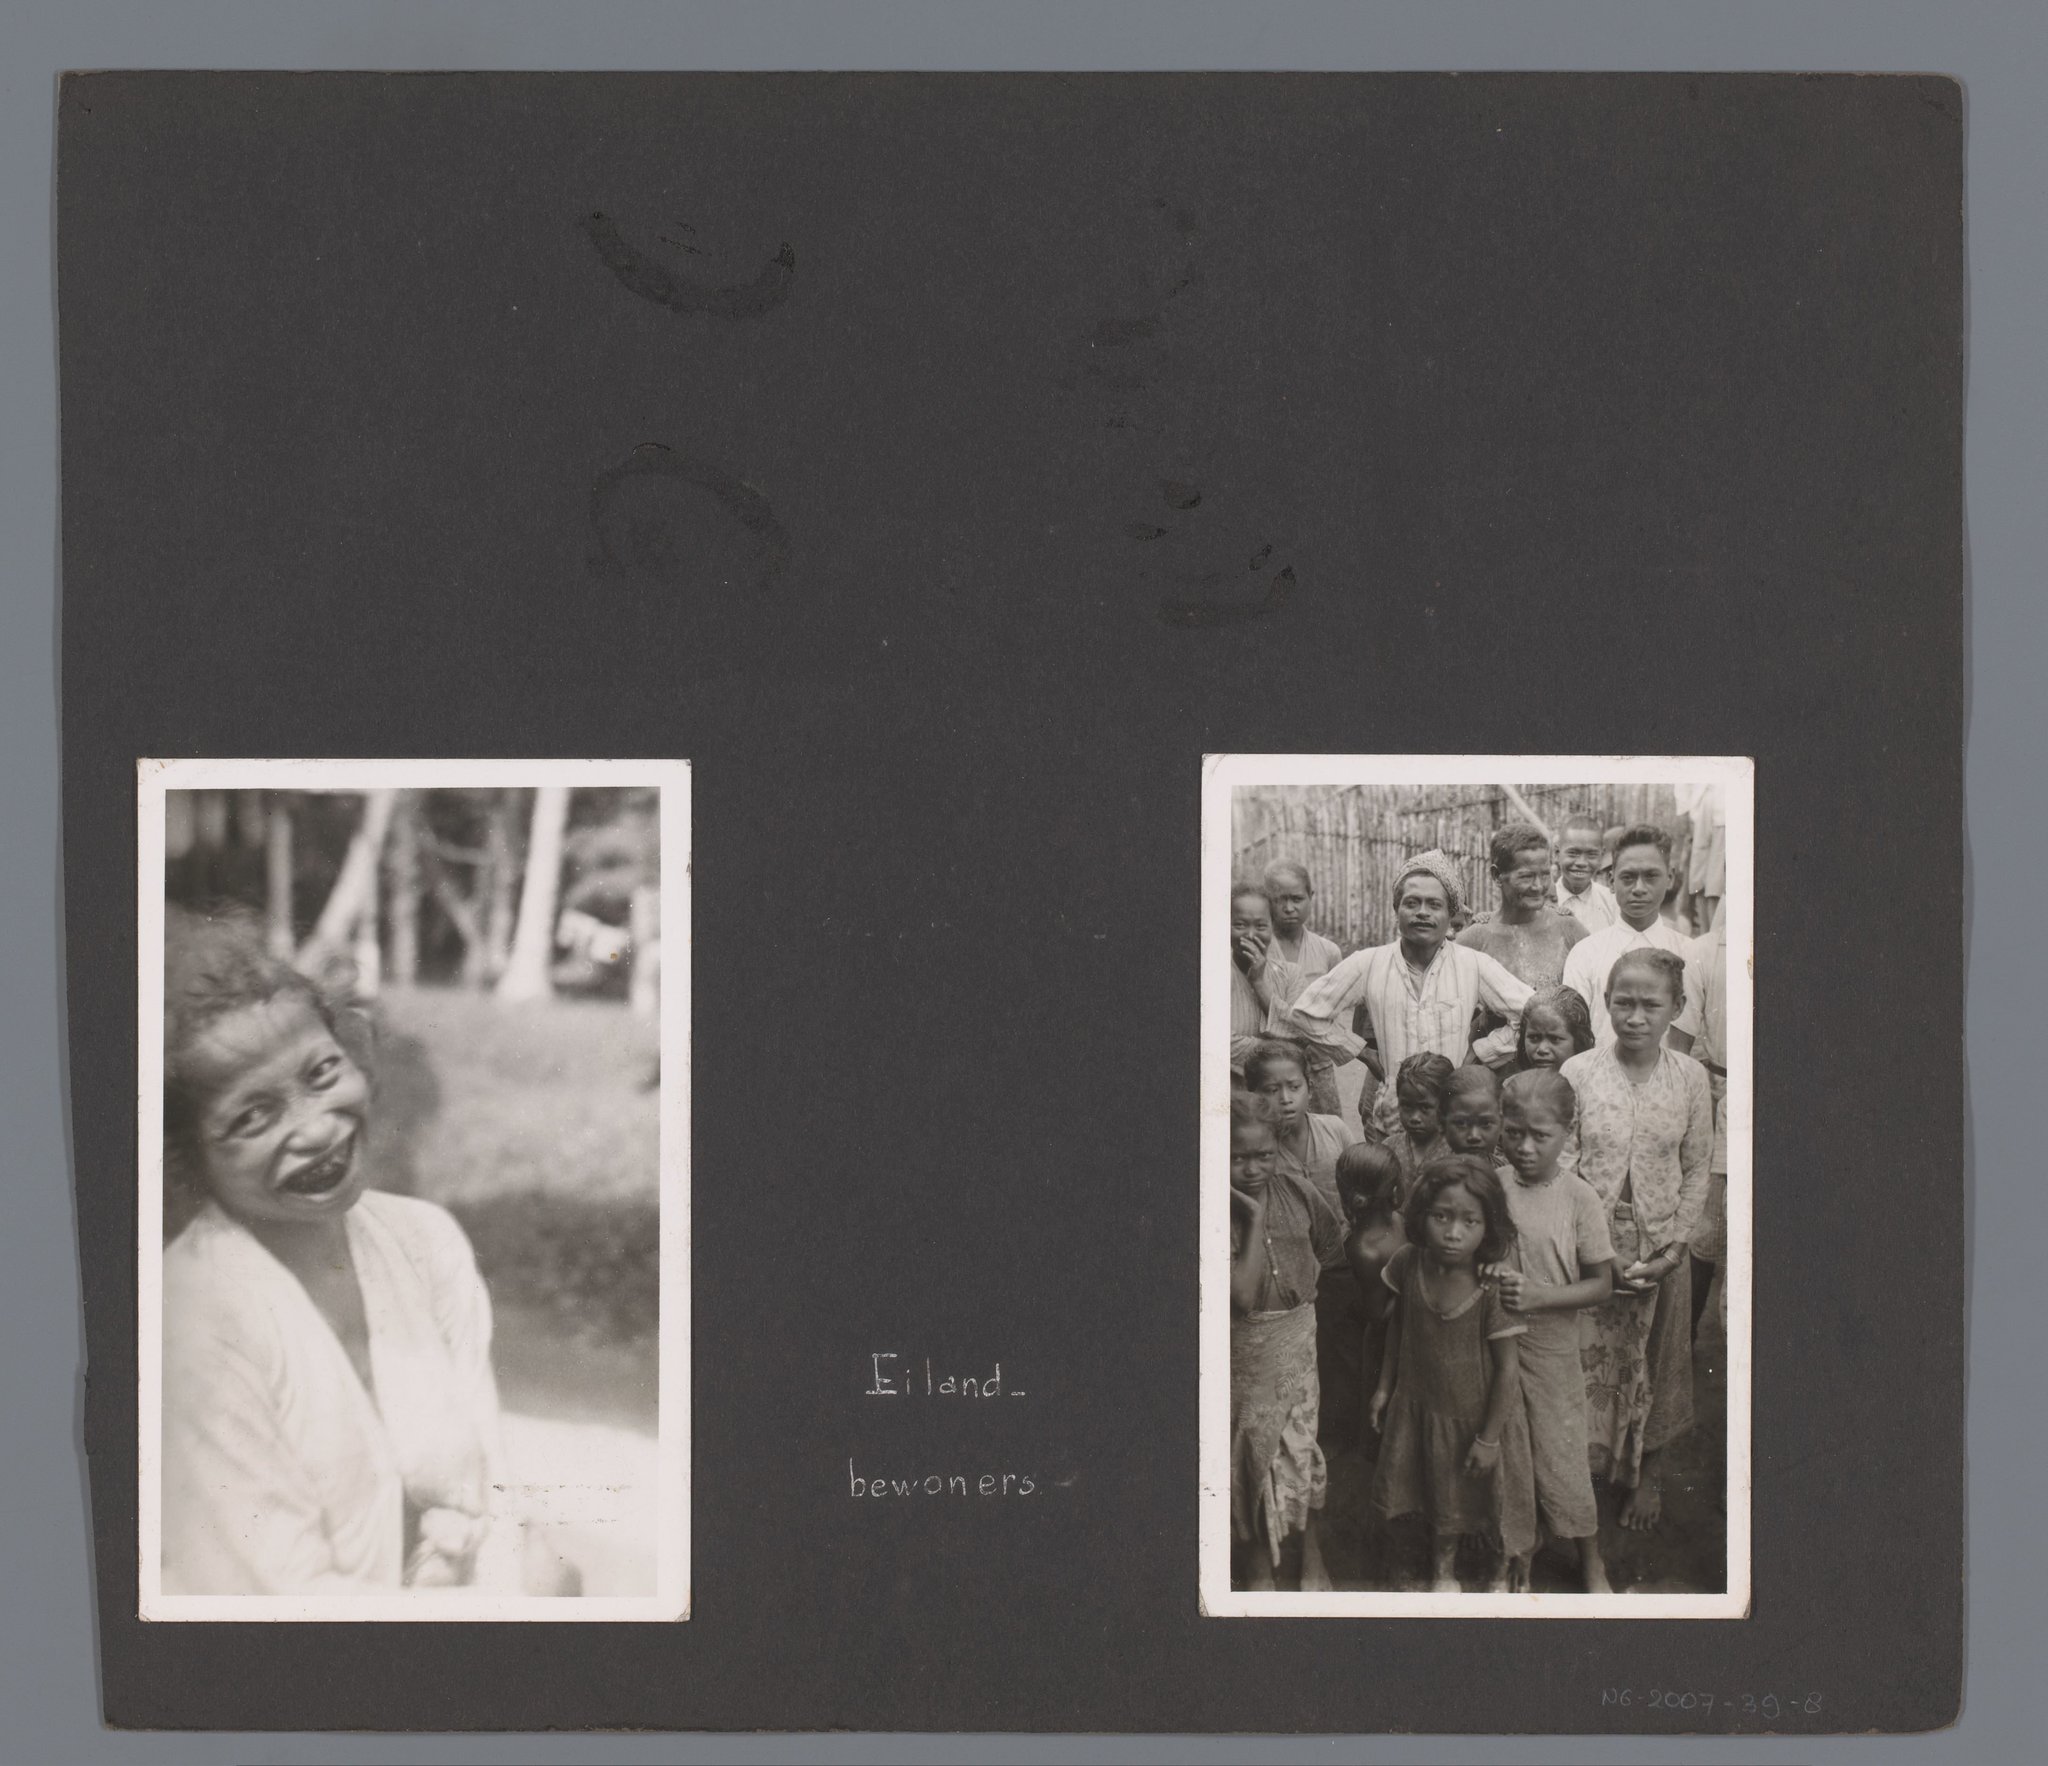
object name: photograph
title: Eiland-bewoners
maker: Anonymous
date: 1930-1939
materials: paper, photographic support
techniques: gelatin silver print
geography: celebes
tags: asiatic races and peoples (indonesians)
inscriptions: annotation: ‘Eiland-bewoners’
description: Zwart albumblad met drie foto's van bewoners van het eiland Celebes. Onderdeel van het losbladig fotoalbum over de Fraters van Tilburg op Celebes en Sumatra.